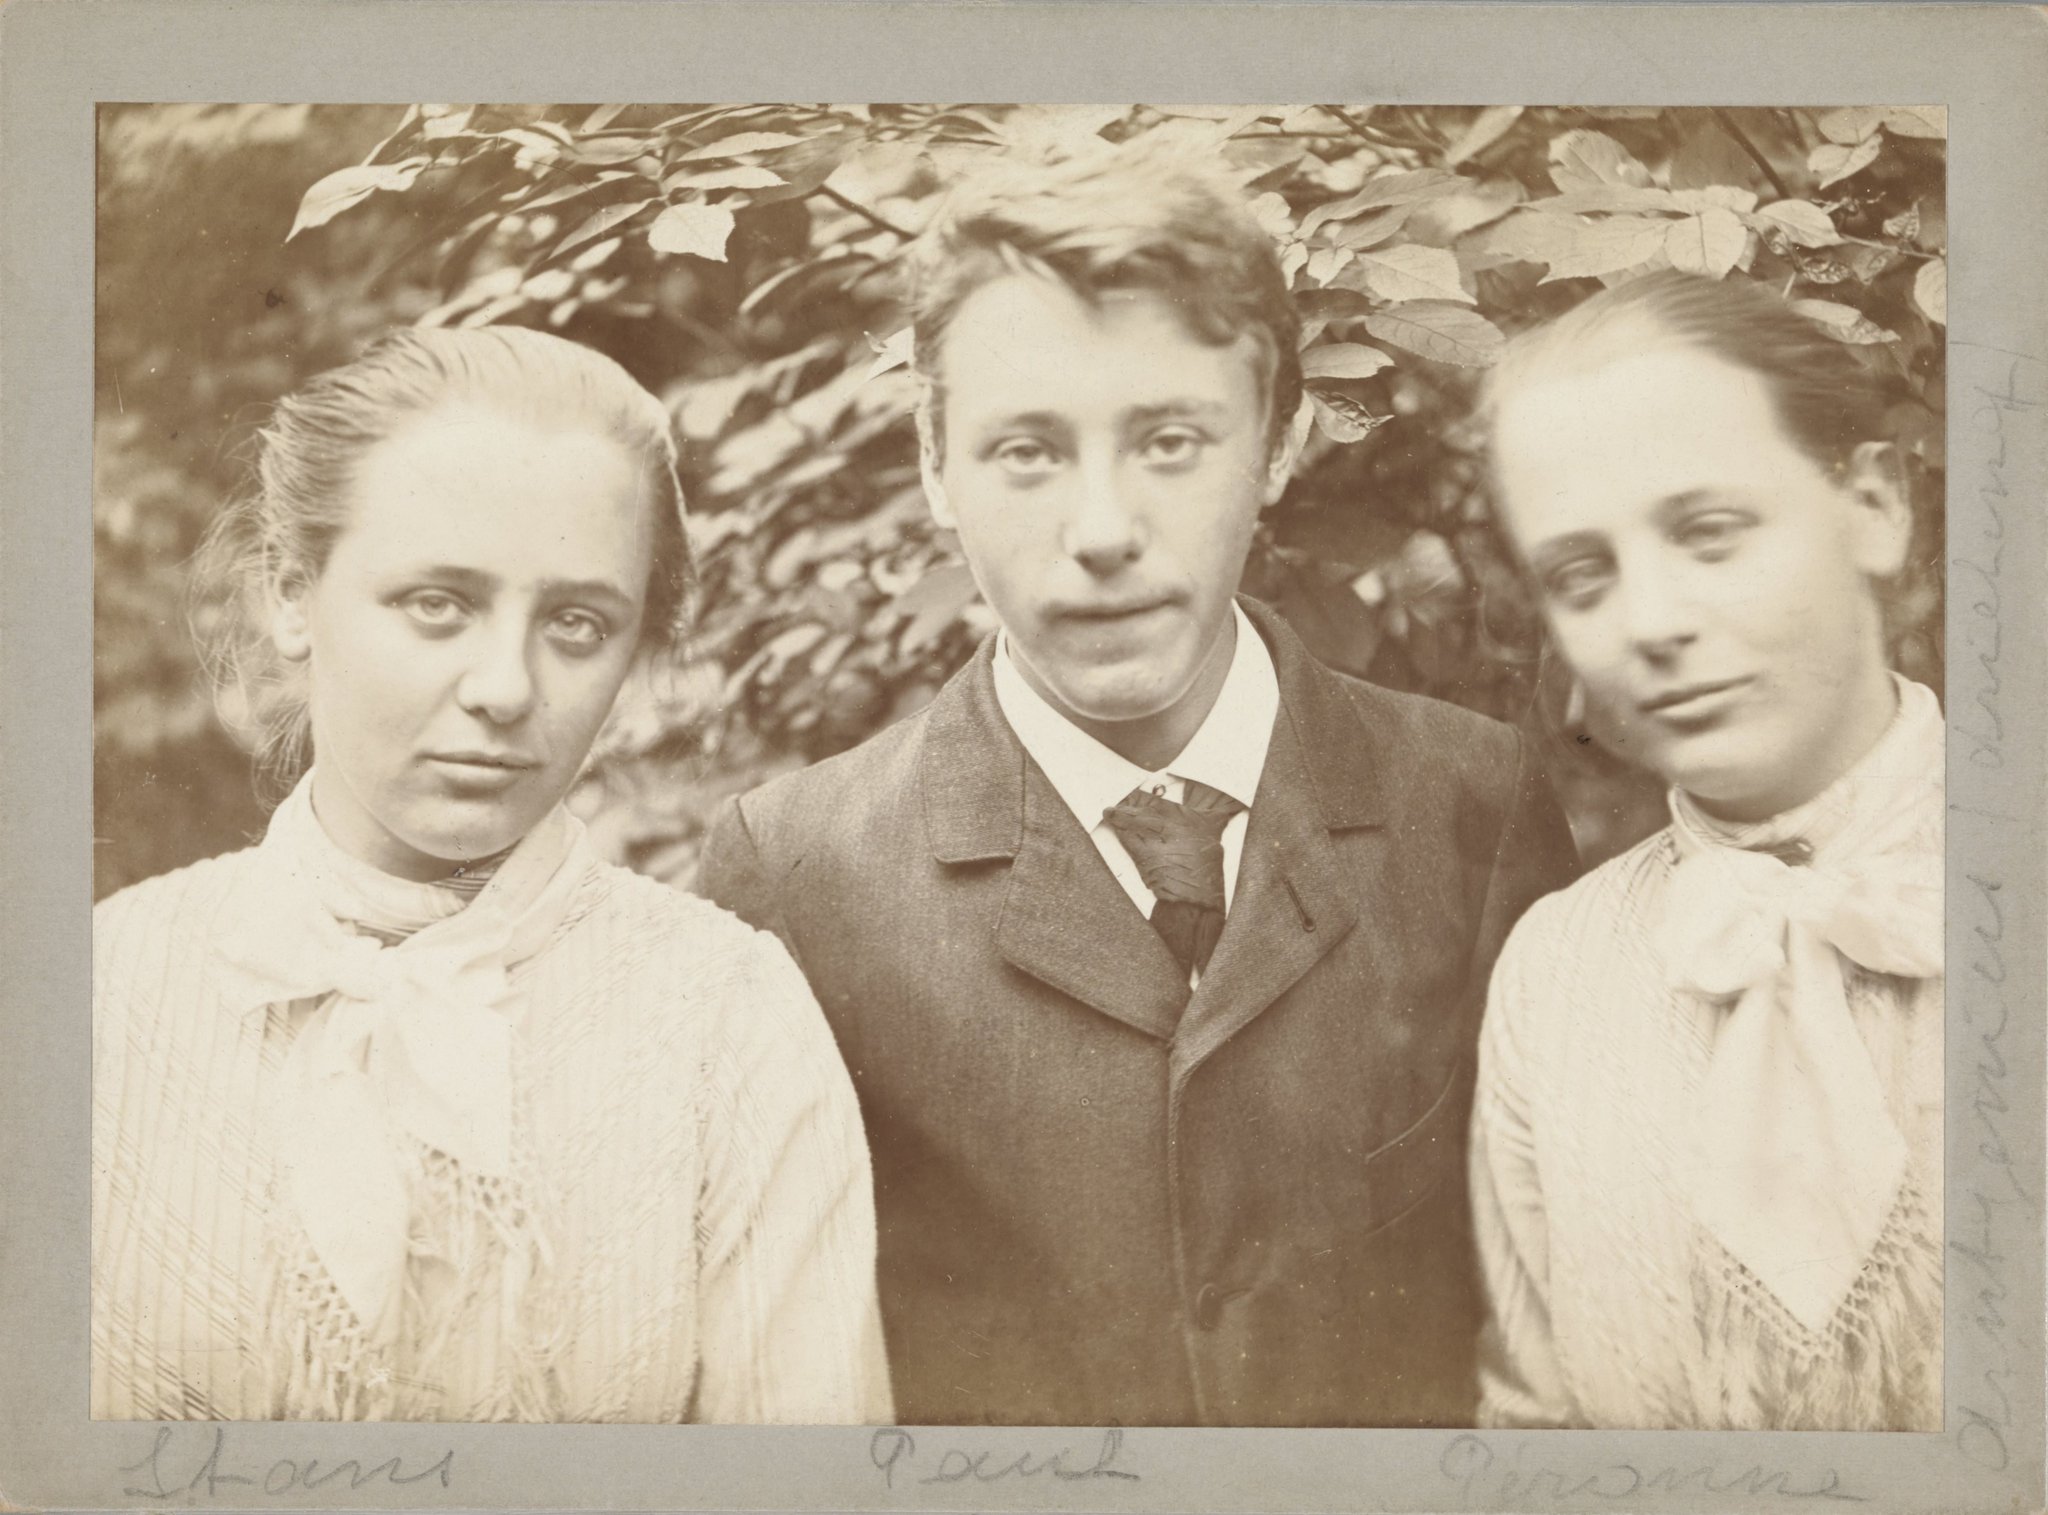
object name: photograph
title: Drieling Stans, Paul en Peronne Arntzenius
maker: willem witsen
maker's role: draughtsman, painter, print maker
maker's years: 1860-1923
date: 1860-1915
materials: cardboard, paper, photographic support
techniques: gelatin silver print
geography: amsterdam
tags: péronne arntzenius